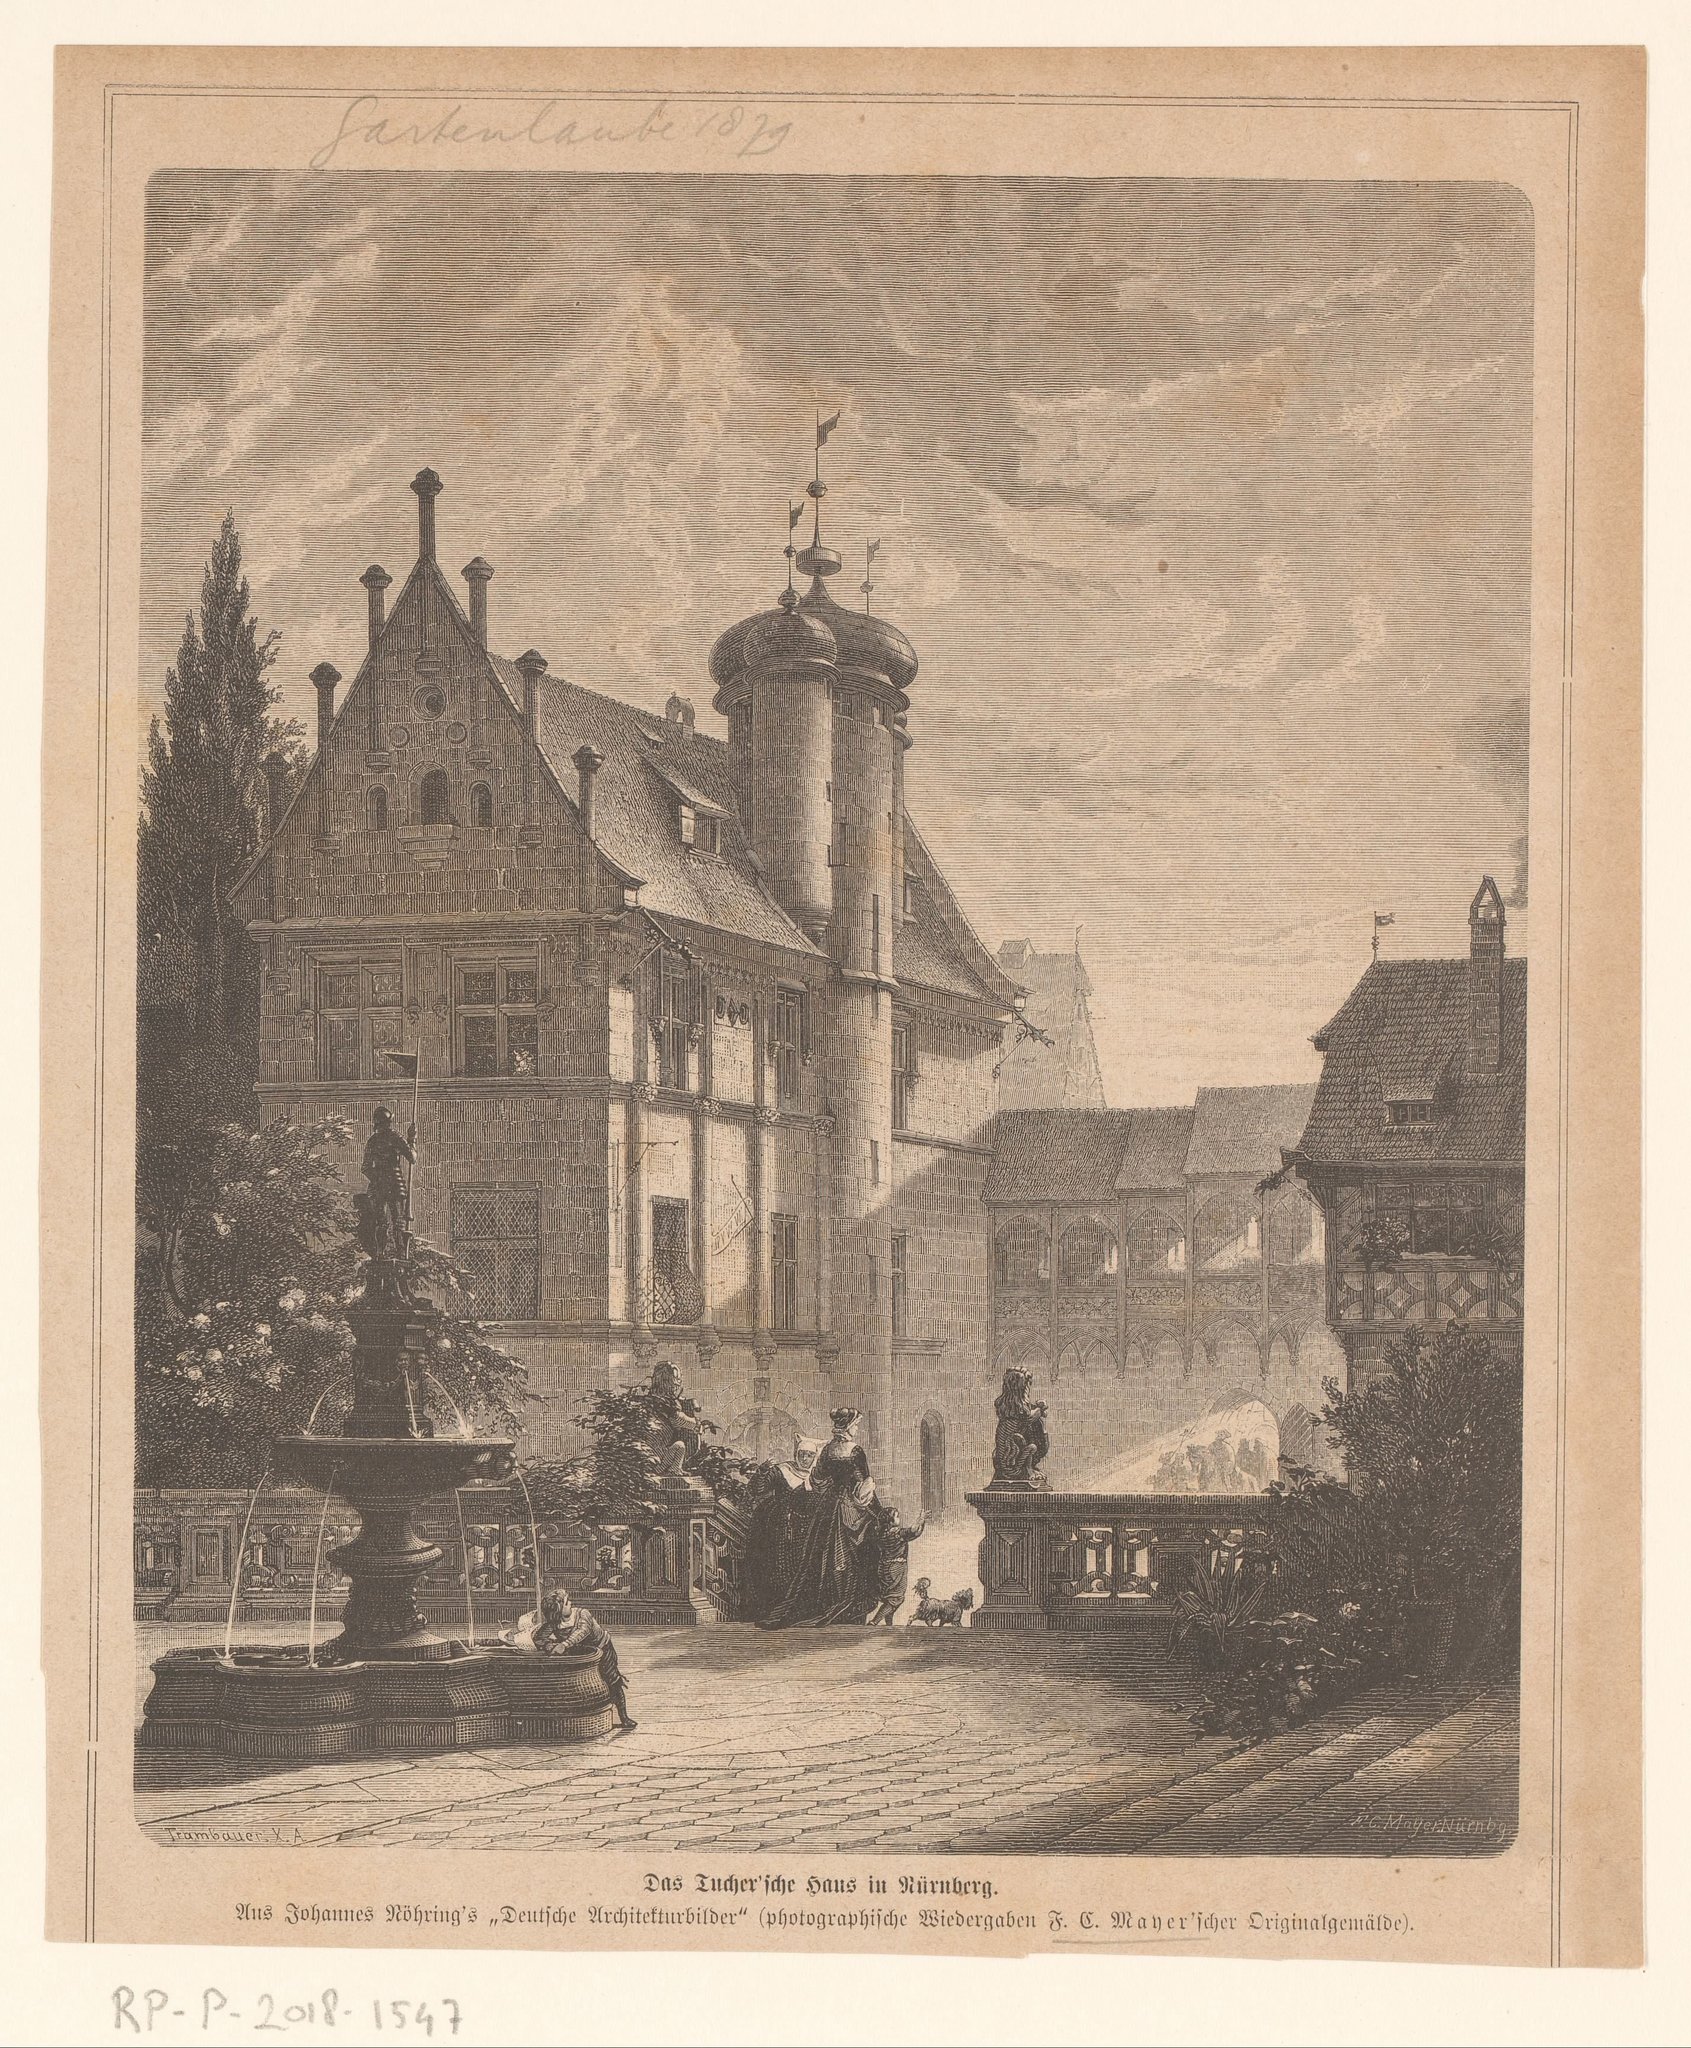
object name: print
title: Das Tuchersche Haus in Nürnberg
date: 1879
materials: paper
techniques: letterpress printing, engraving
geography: nuremberg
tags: fortified house in city